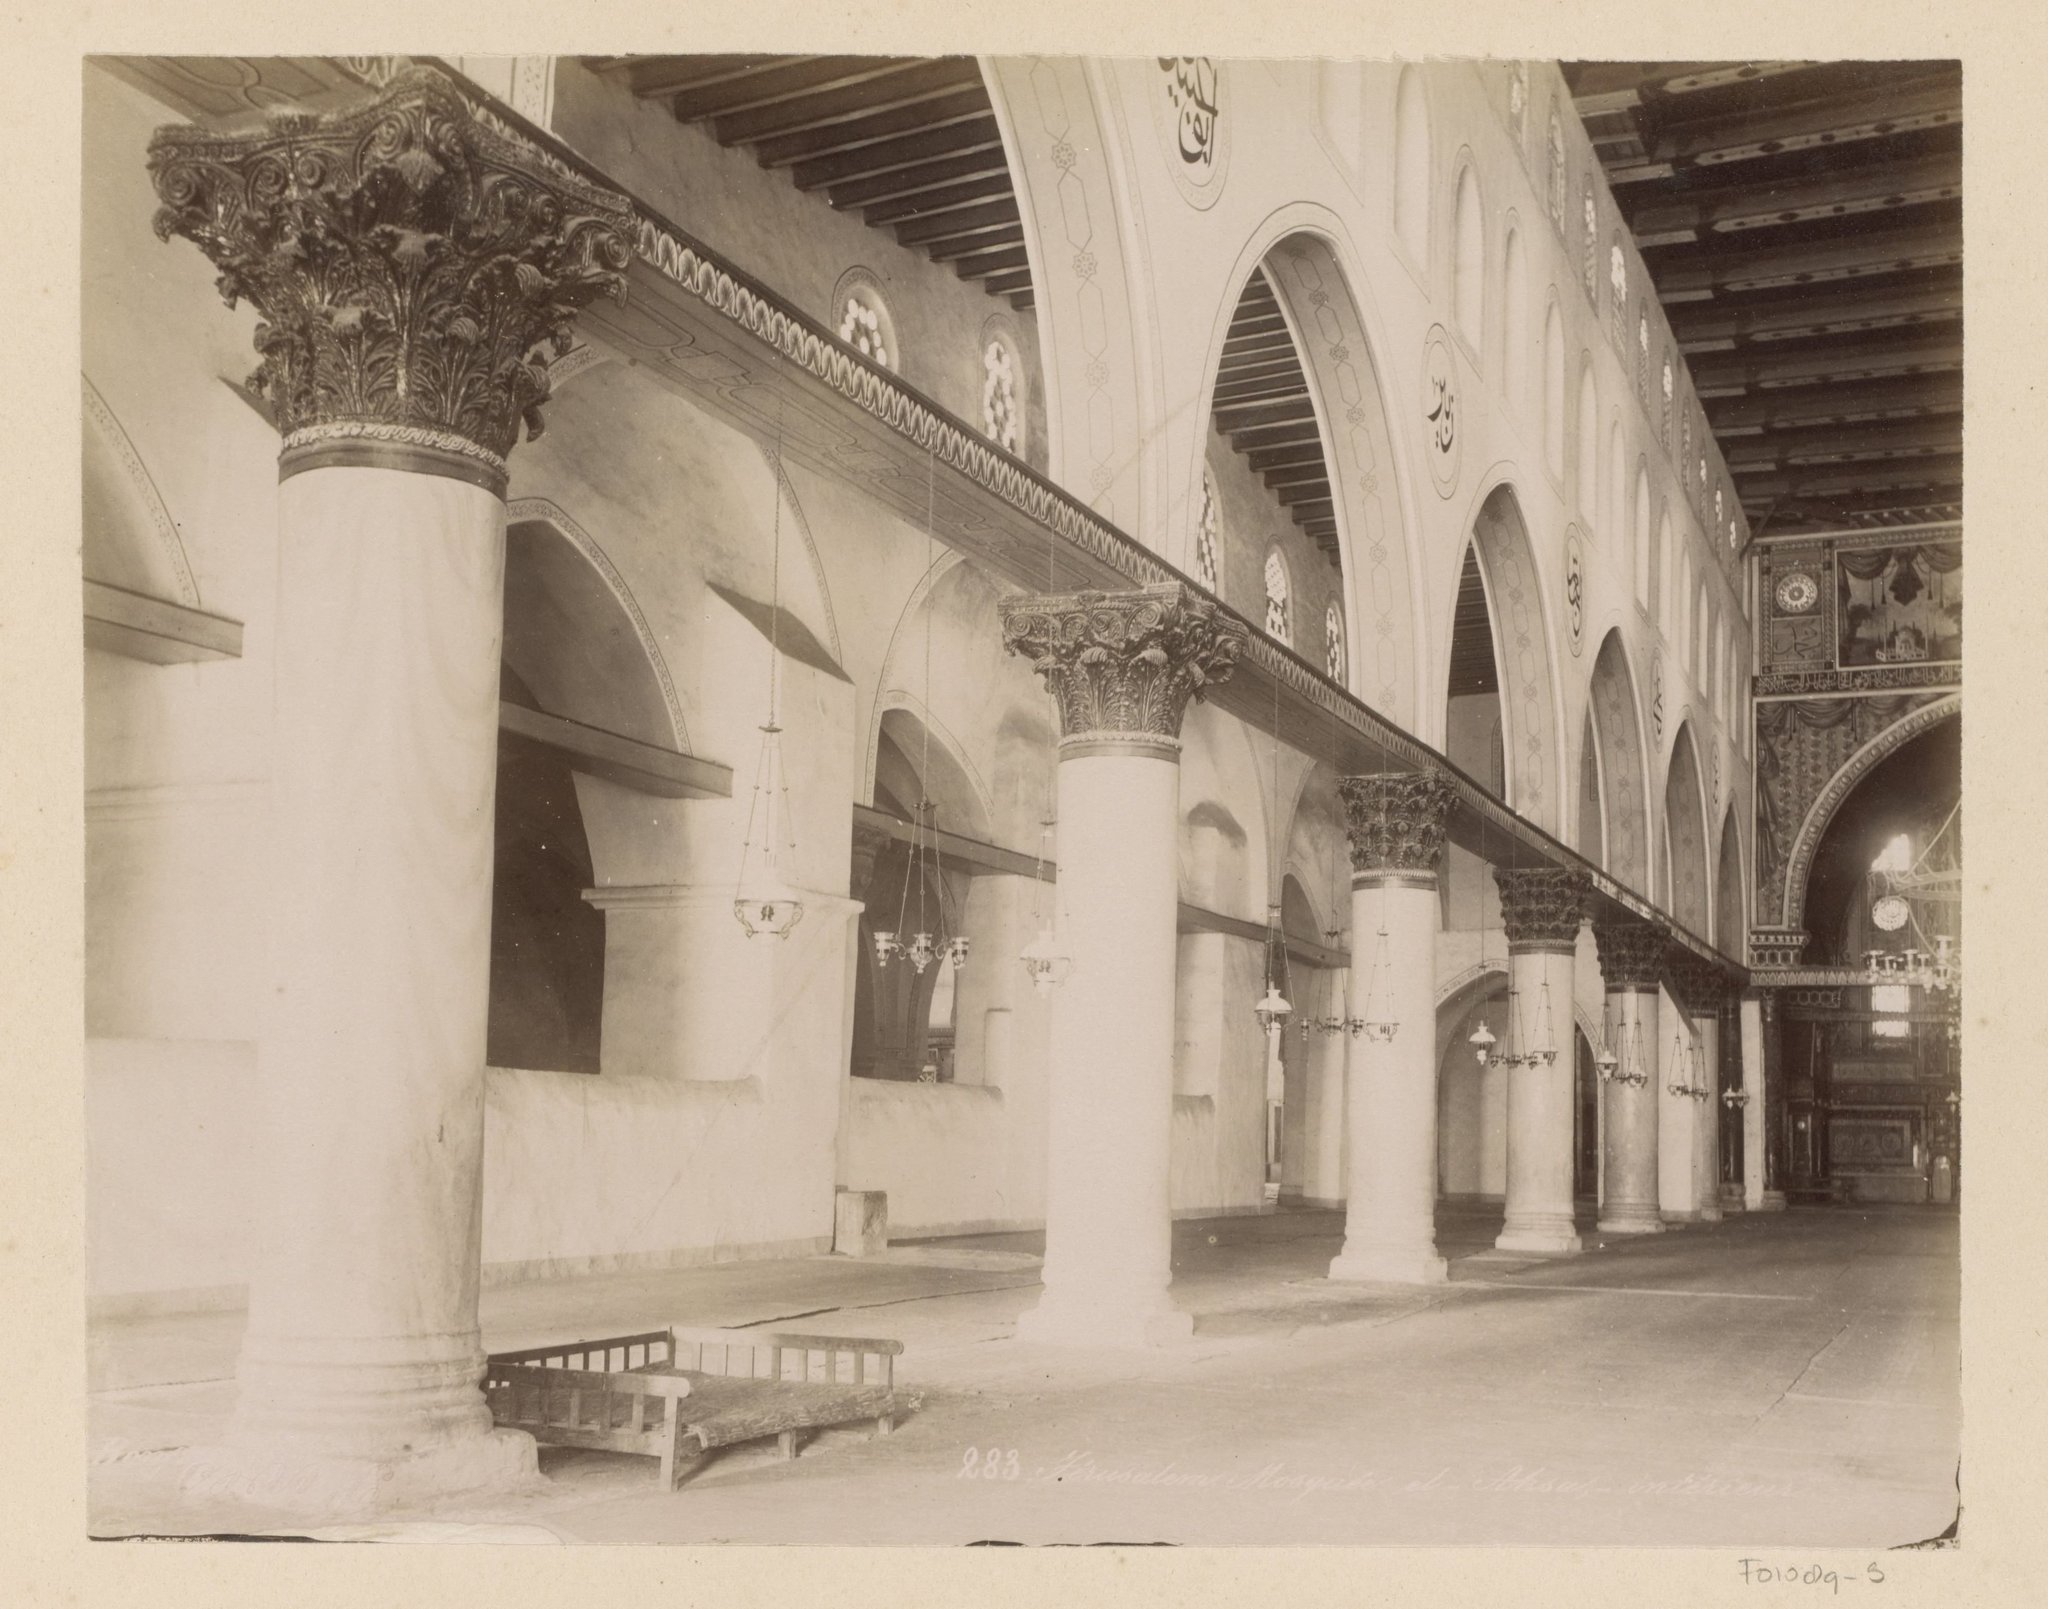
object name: photograph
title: Interieur van de Al-Aqsamoskee op de Tempelberg in Jeruzalem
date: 1867-1895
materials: cardboard, paper, photographic support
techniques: albumen print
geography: jerusalem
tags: temple, shrine ~ islam, mohammedanism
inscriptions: inscription: ‘BFK Rives’, negative number: ‘283’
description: Onderdeel van Reisalbum met foto's van Jeruzalem en andere bijbelse plaatsen.